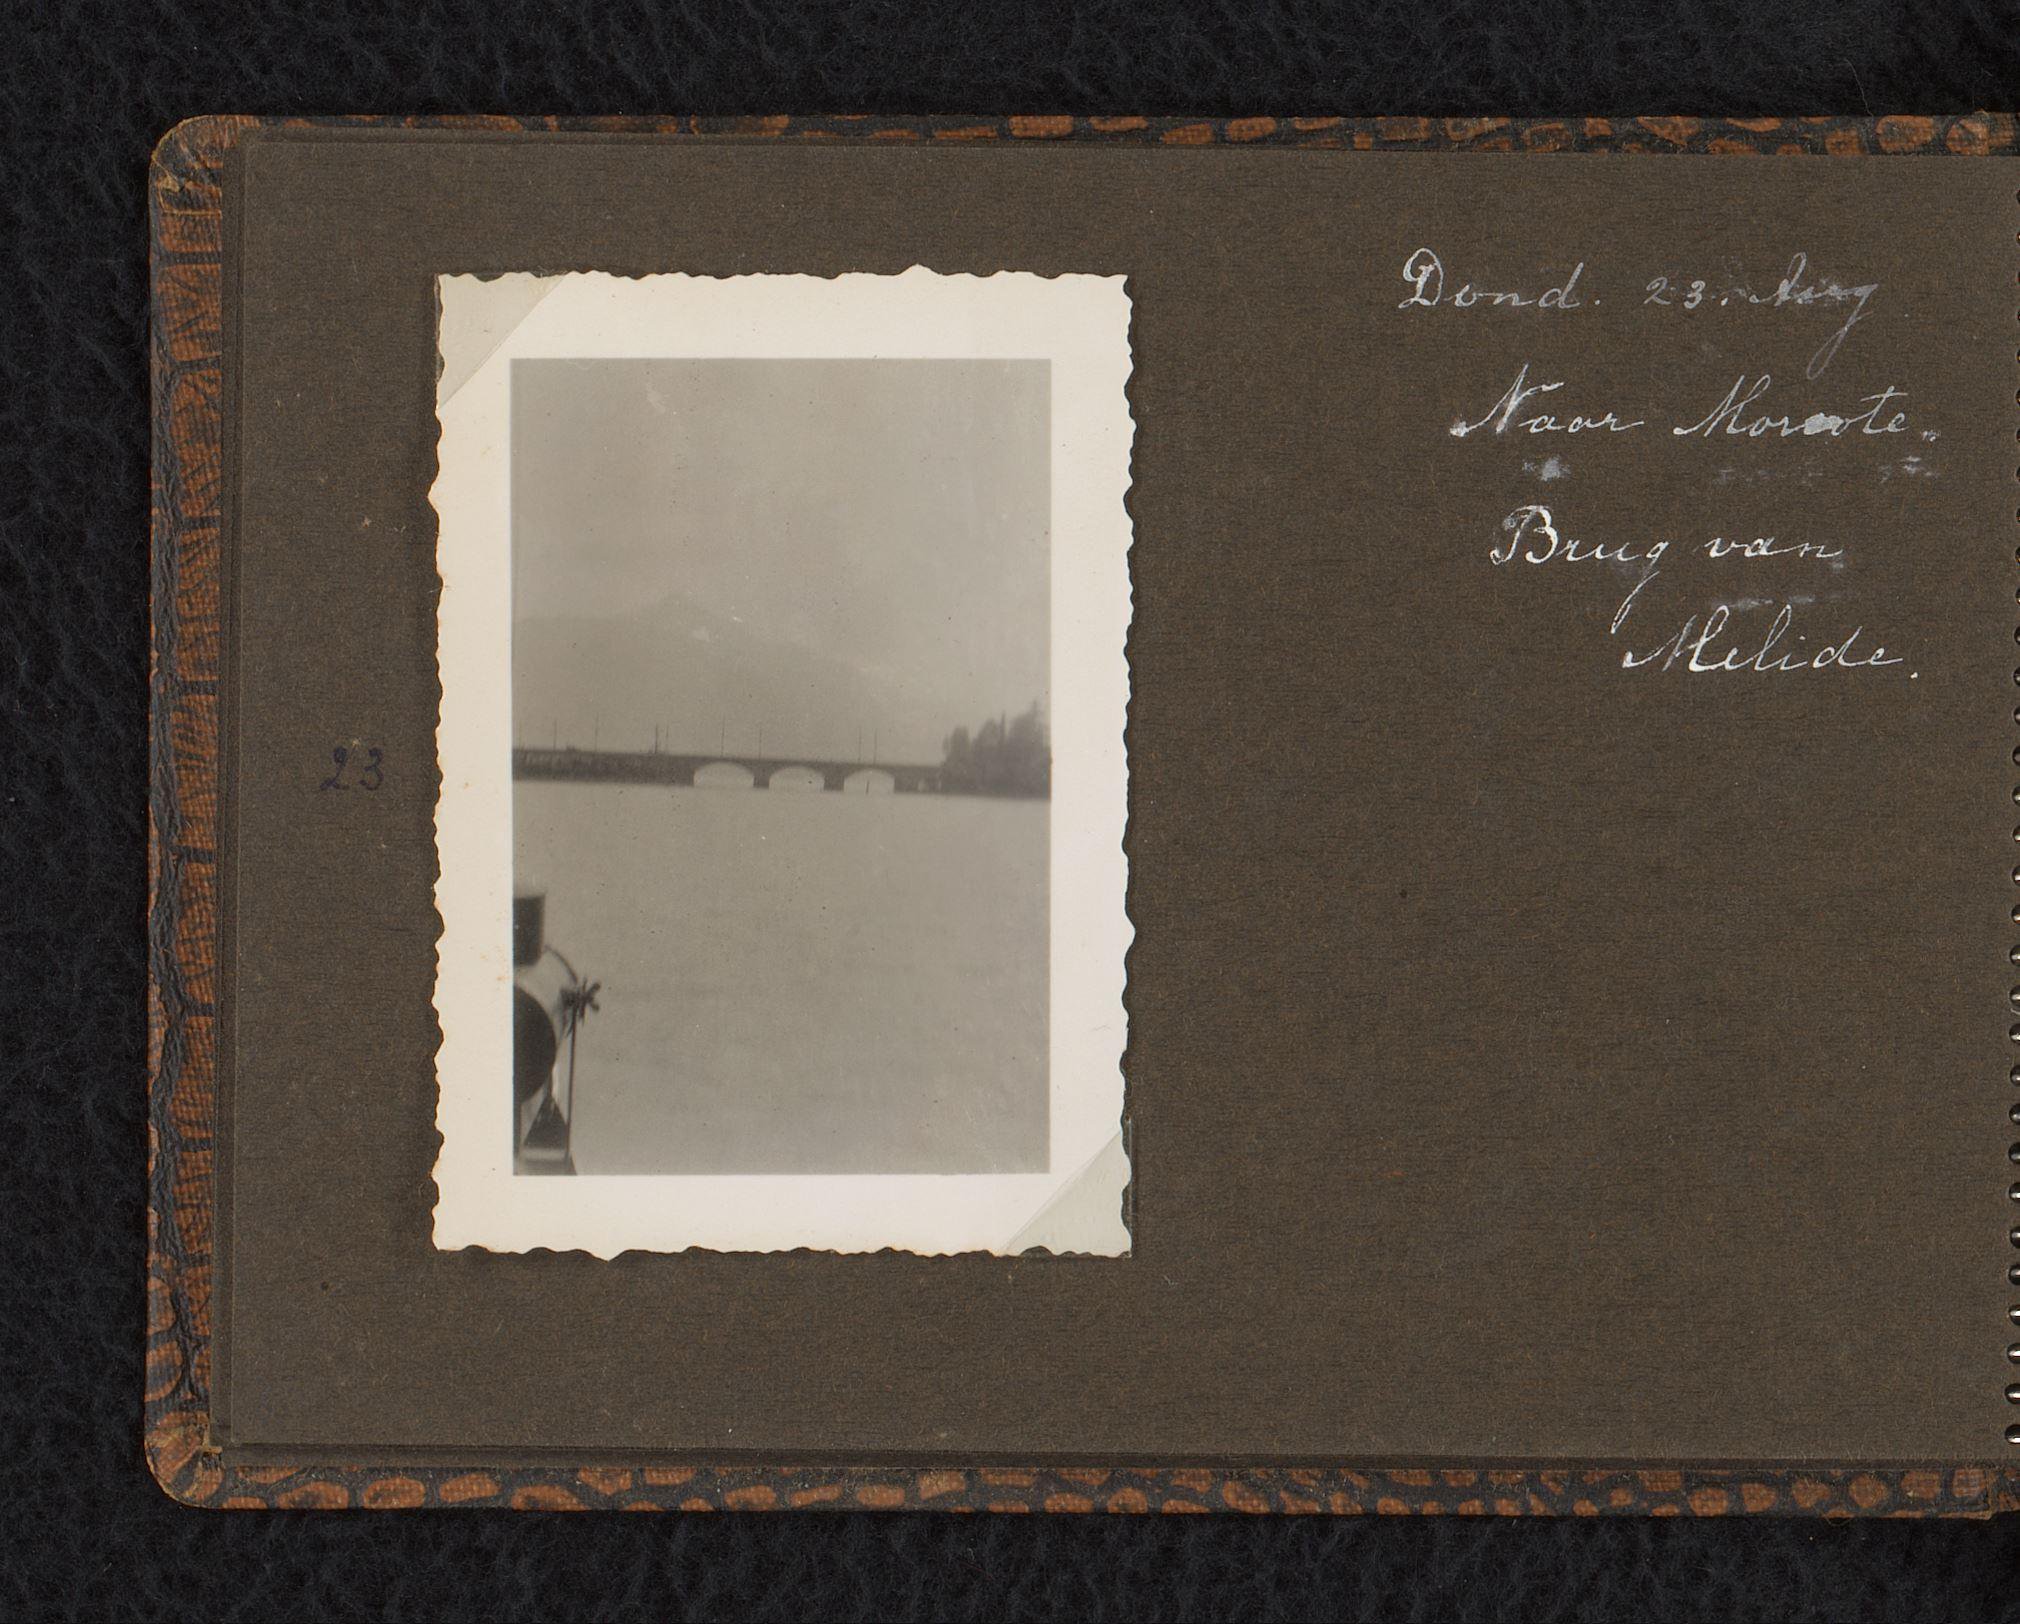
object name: photograph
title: Gezicht op de brug bij Melide over het meer van Lugano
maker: Anonymous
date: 1934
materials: paper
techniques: gelatin silver print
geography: lake lugano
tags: lake, bridge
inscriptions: number: ‘23’